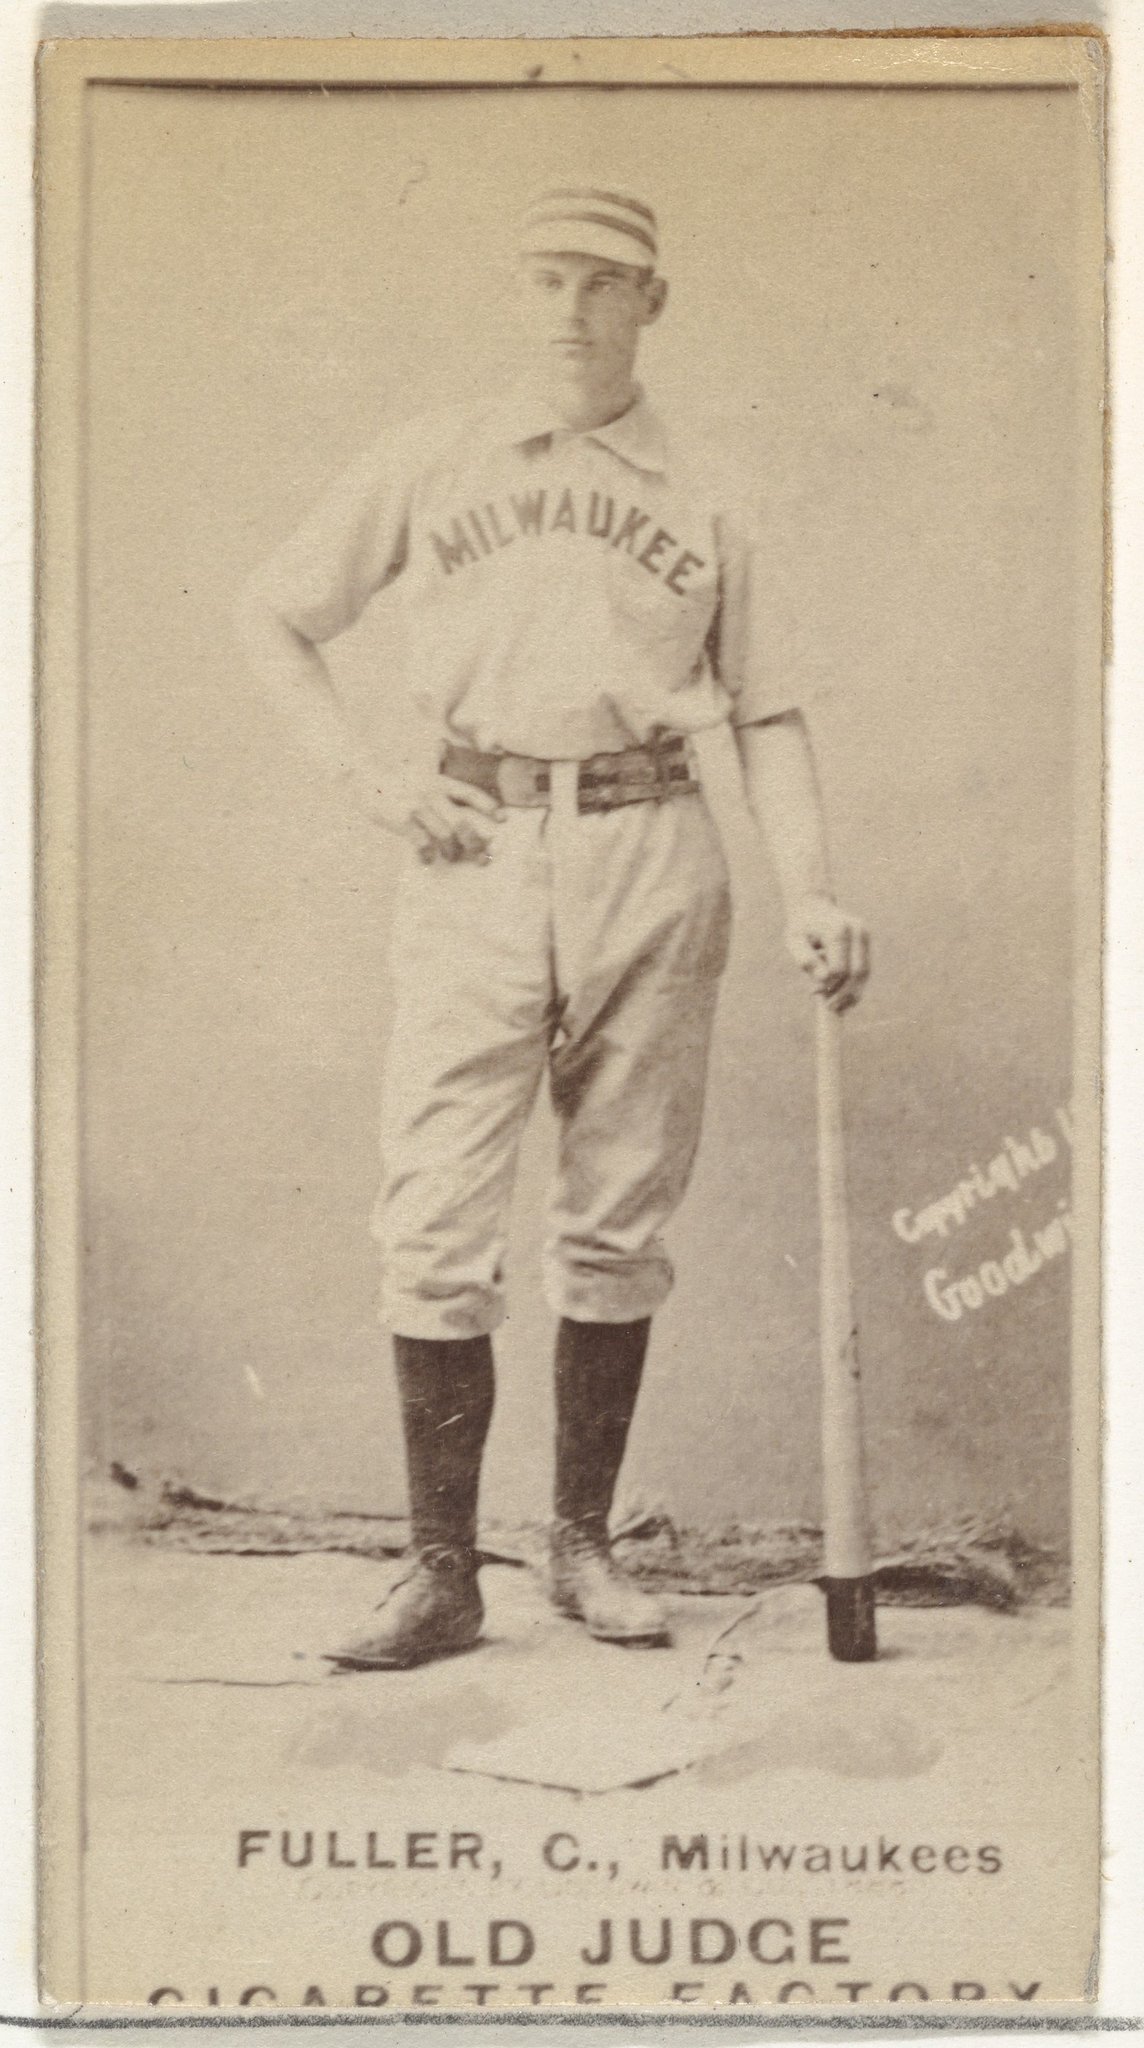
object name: baseball card, photograph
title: William E. "Will" Fuller, Catcher, Milwaukee, from the Old Judge series (N172) for Old Judge Cigarettes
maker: goodwin & company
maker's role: publisher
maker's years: 1850-1950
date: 1888-1889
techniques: albumen silver print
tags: men,portraits,baseball,athletes